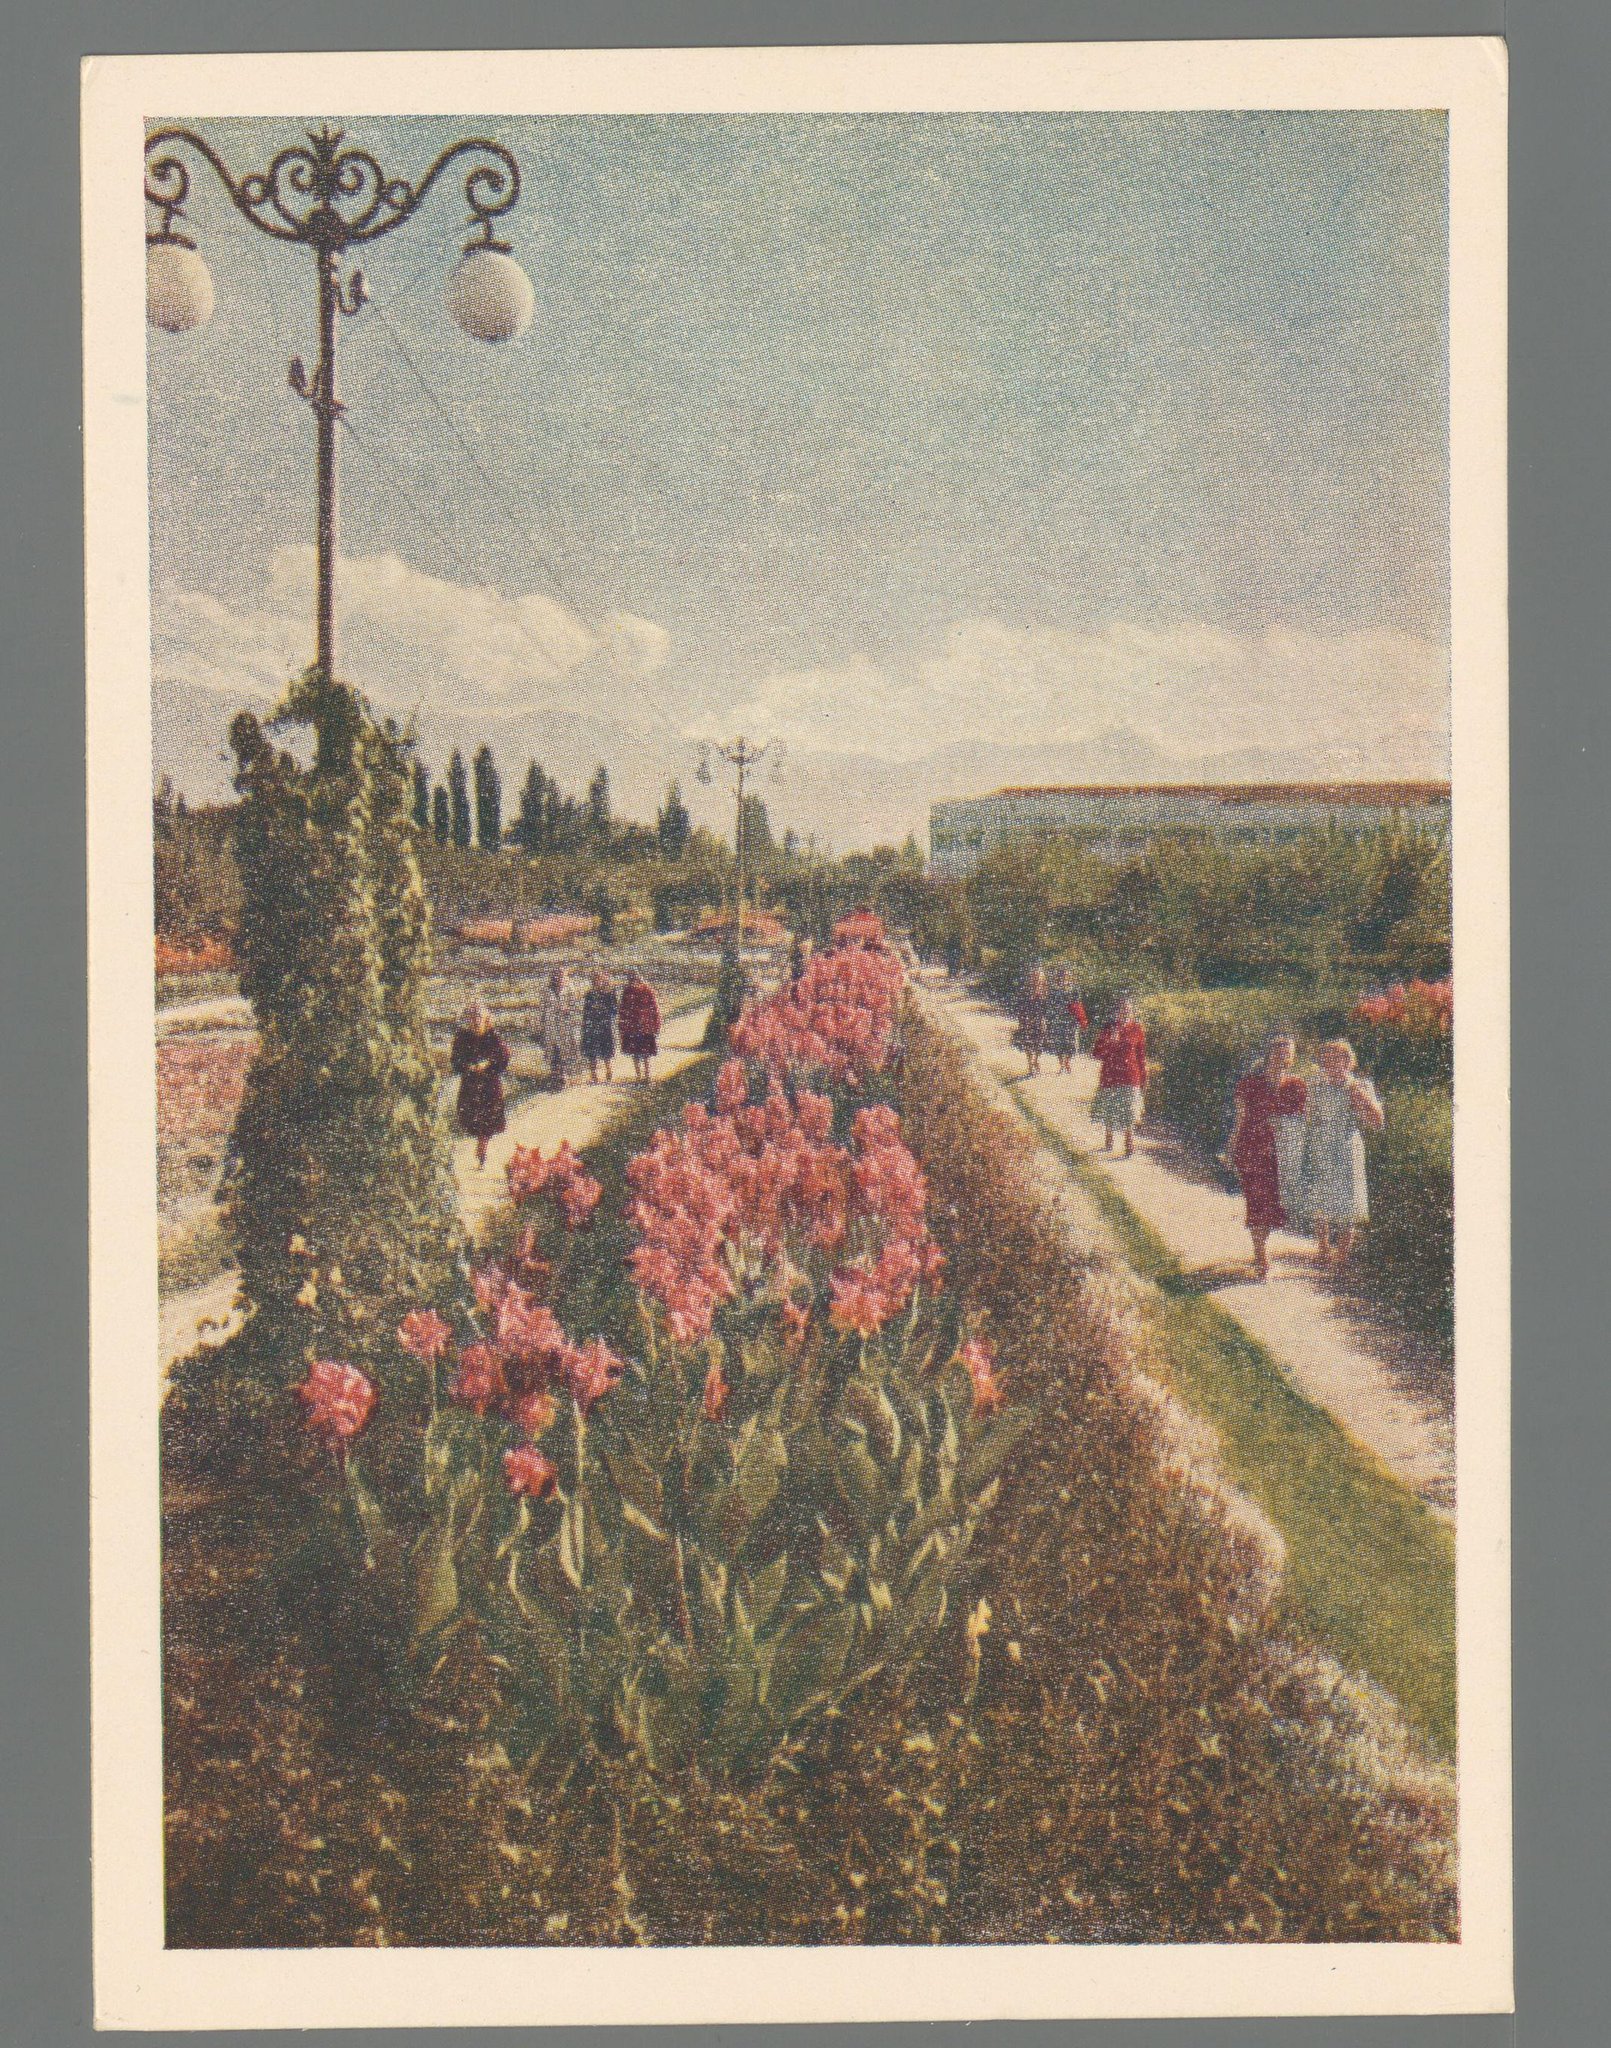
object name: photomechanical print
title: Kazakh S.S.R. Alma-Ata. Flowers Square / R.S.S. de Kazakhie. Alma-Ata. Place des fleurs / Kasachische SSR. Alma-Ata. Blumen-Platz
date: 1956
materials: cardboard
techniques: color autotype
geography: moscow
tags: flowers, square, place, circus, etc.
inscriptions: date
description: De titel op object staat ook in het Russisch.